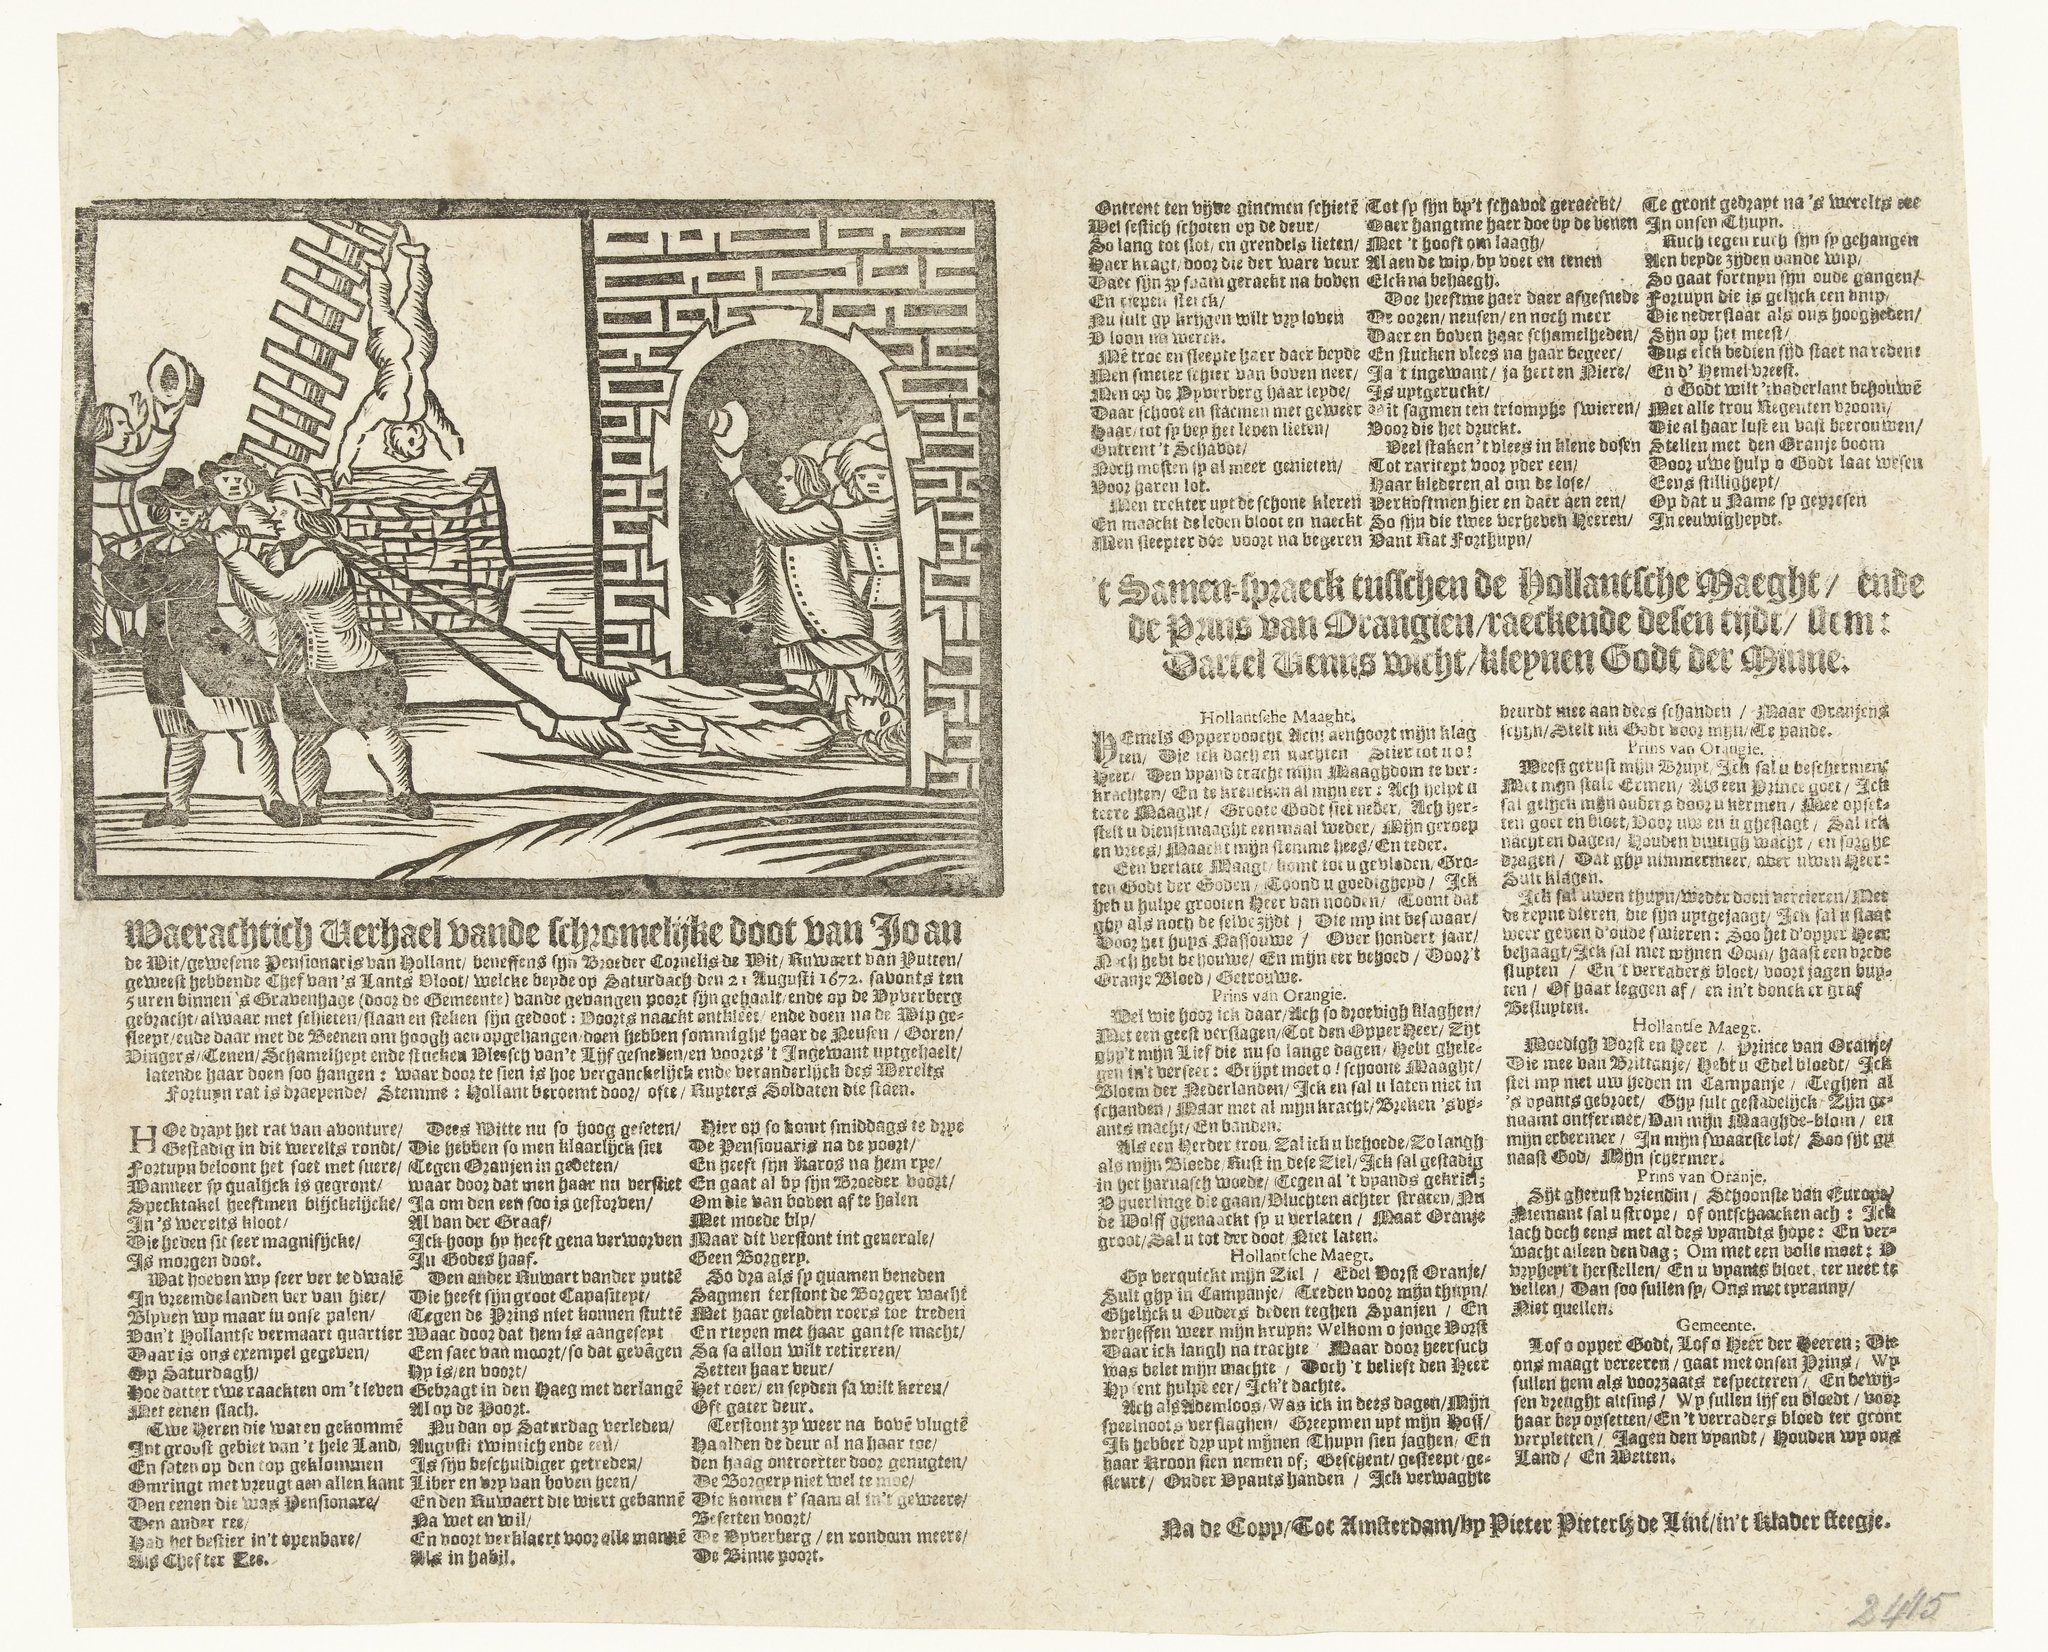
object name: print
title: Waerachtich Verhael vande schromelijke doot van Joan de Wit (...) beneffens sijn Broeder Cornelis de Wit (...) op Saturdach den 21 Augusti 1672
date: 1672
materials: paper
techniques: letterpress printing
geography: amsterdam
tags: cornelis de witt, politician, johan de witt, lynching, attempt, political murder, violent death, being killed; being mishandled and maltreated; seeking death (+ death by lynching), the hague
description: De lichamen van de gebroeders Johan en Cornelis de Witt worden uit de Gevangenpoort gesleept en op de wip gehangen, 20 augustus 1672. Zowel onder als rechts drie kolommen tekst met in het tweede deel een samenspraak tussen de Hollandse Maagd en de prins van Oranje.